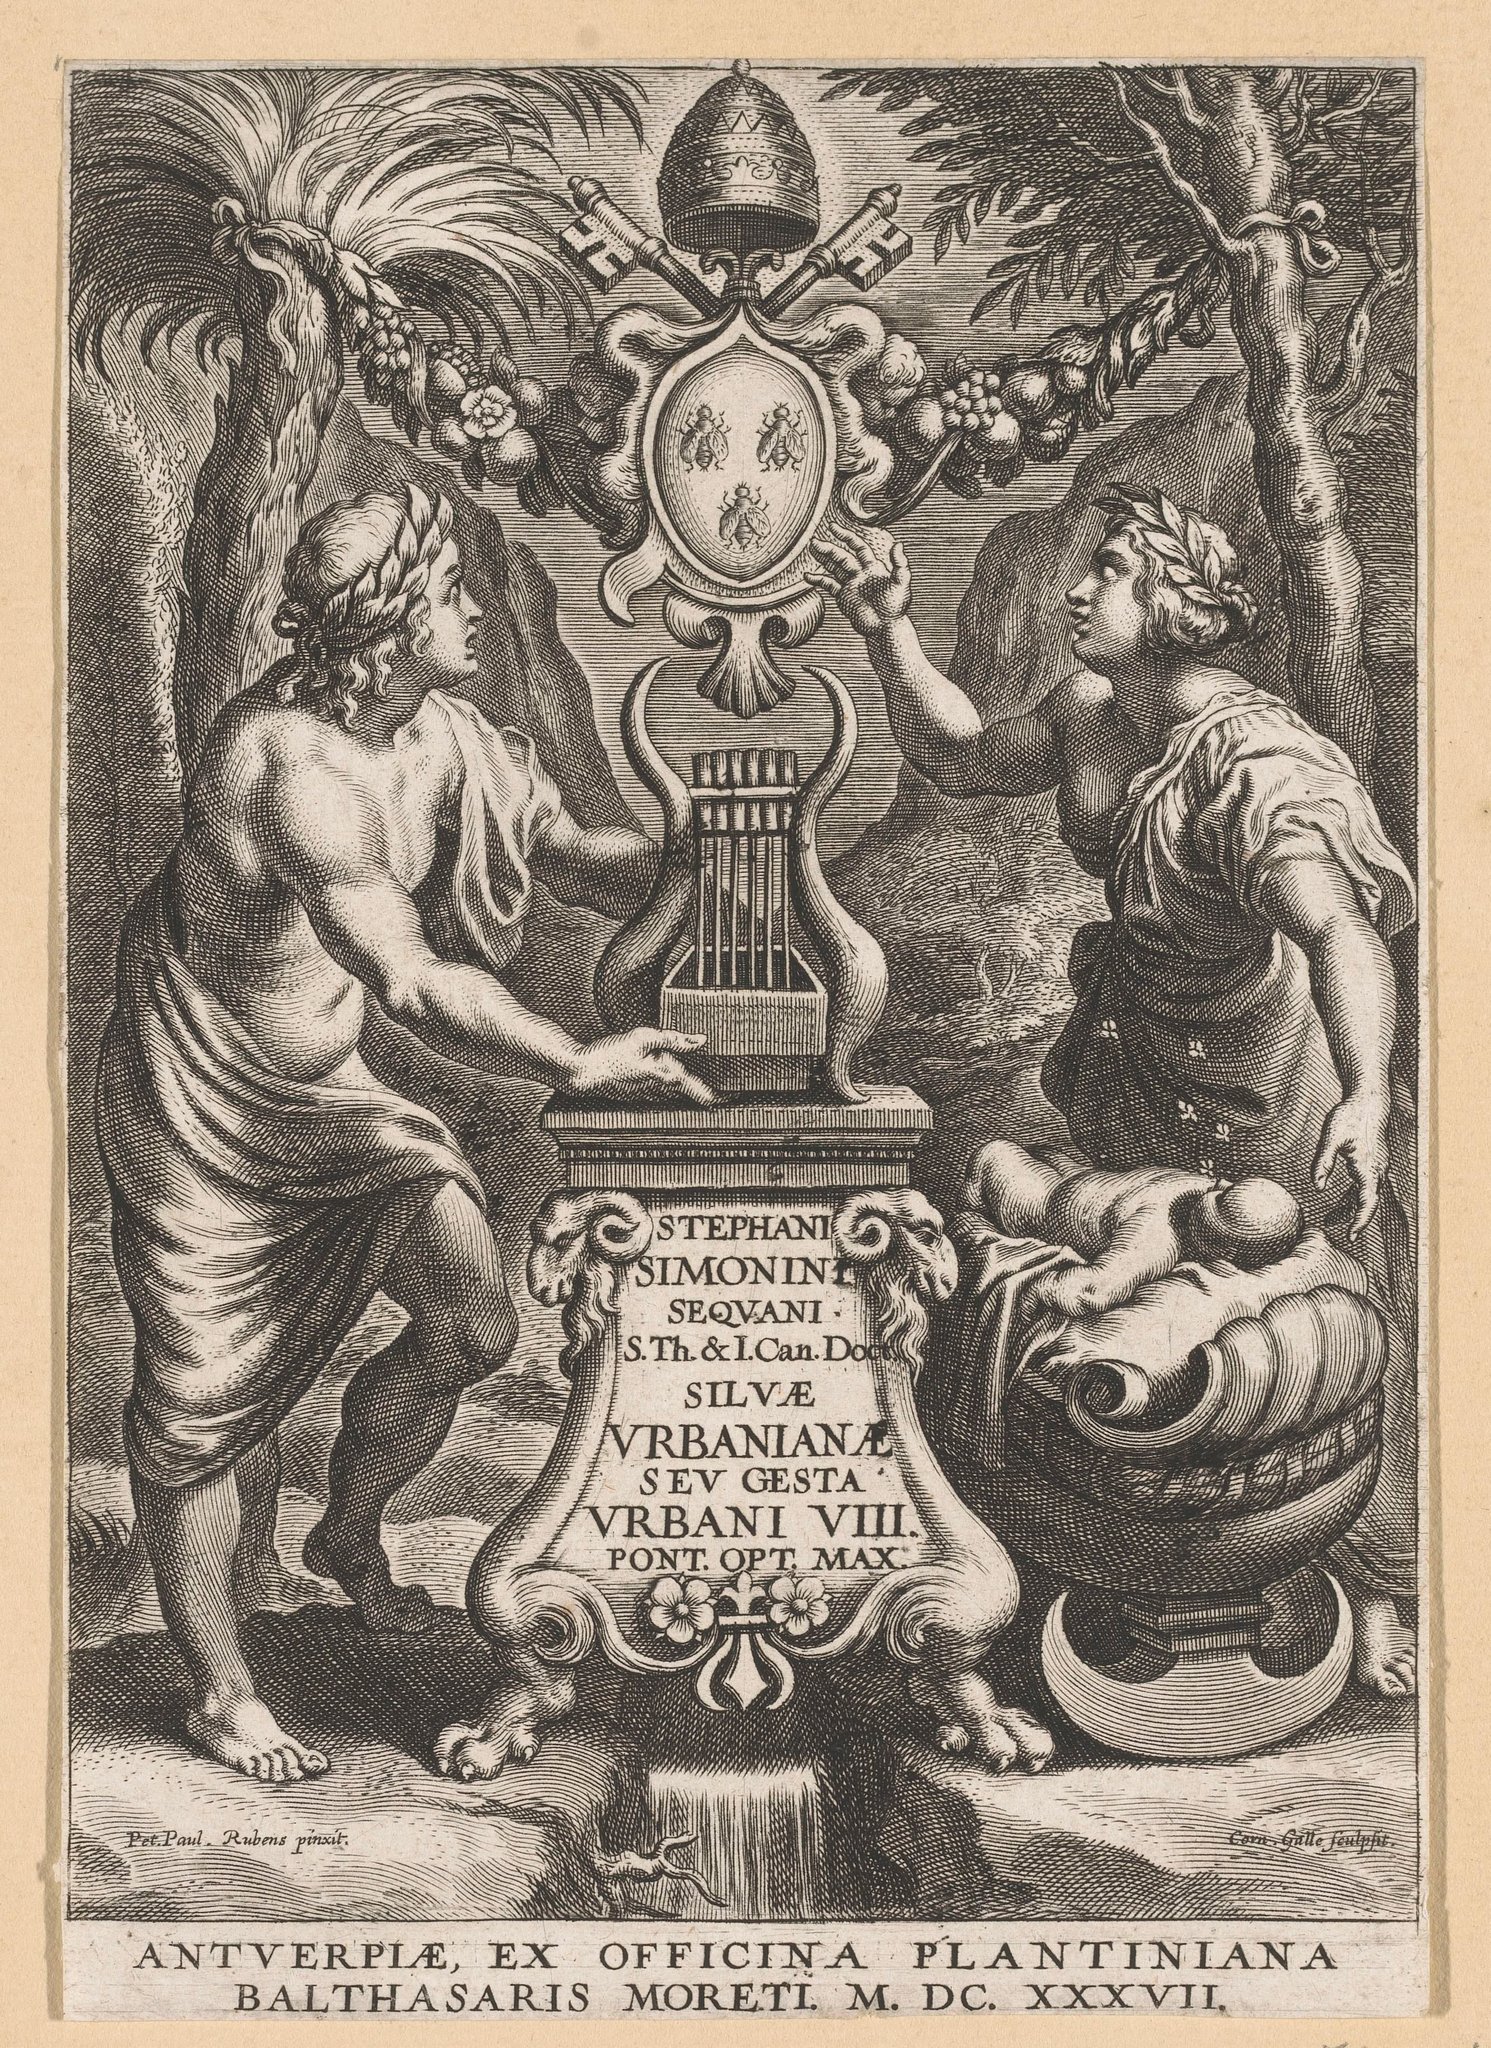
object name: print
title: Titelpagina voor: S. Simonini, Silvae Urbanianae, Antwerpen, 1637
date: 1637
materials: paper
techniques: engraving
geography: antwerp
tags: (story of) apollo (phoebus), erato (one of the muses); 'erato' (ripa), insects: bee (+ animals used symbolically)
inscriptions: collector's mark: Lugt 240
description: Apollo de god van de kunsten en de muze Erato naast de bron van dichterlijke inspiratie, de Hippocrene. Erato wijst op het wapen van paus Urbanus VIII met drie bijen. In de wieg voor haar ligt de antieke dichter Pindar als kind. Bijen voeden hem met honing.